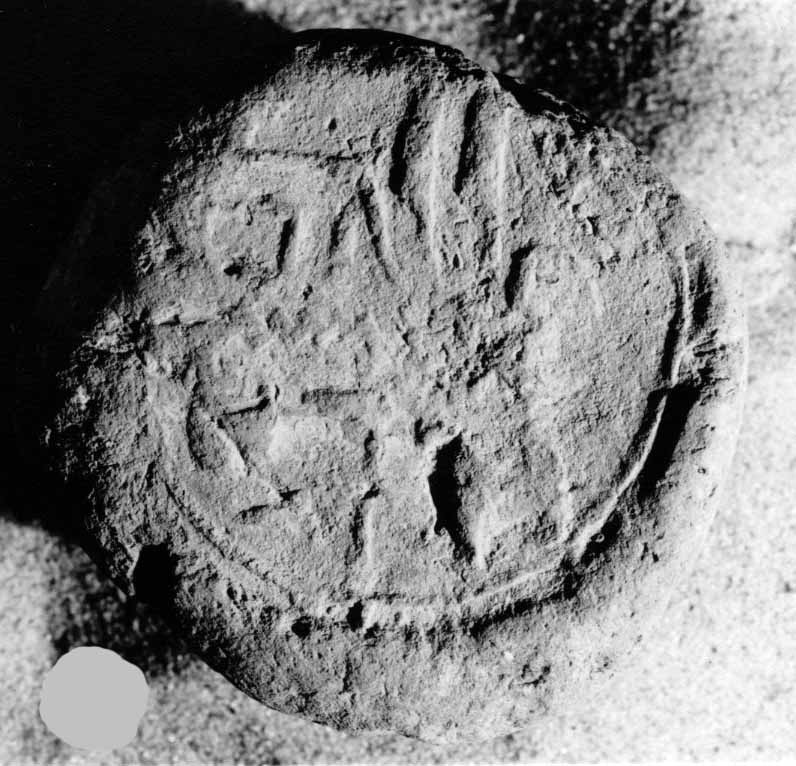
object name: cone, mery, round stamp, steward, god's wife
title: Funerary Cone of the Steward of the God's Wife Mery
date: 1550-1295 BCE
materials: pottery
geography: egypt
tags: hieroglyphs